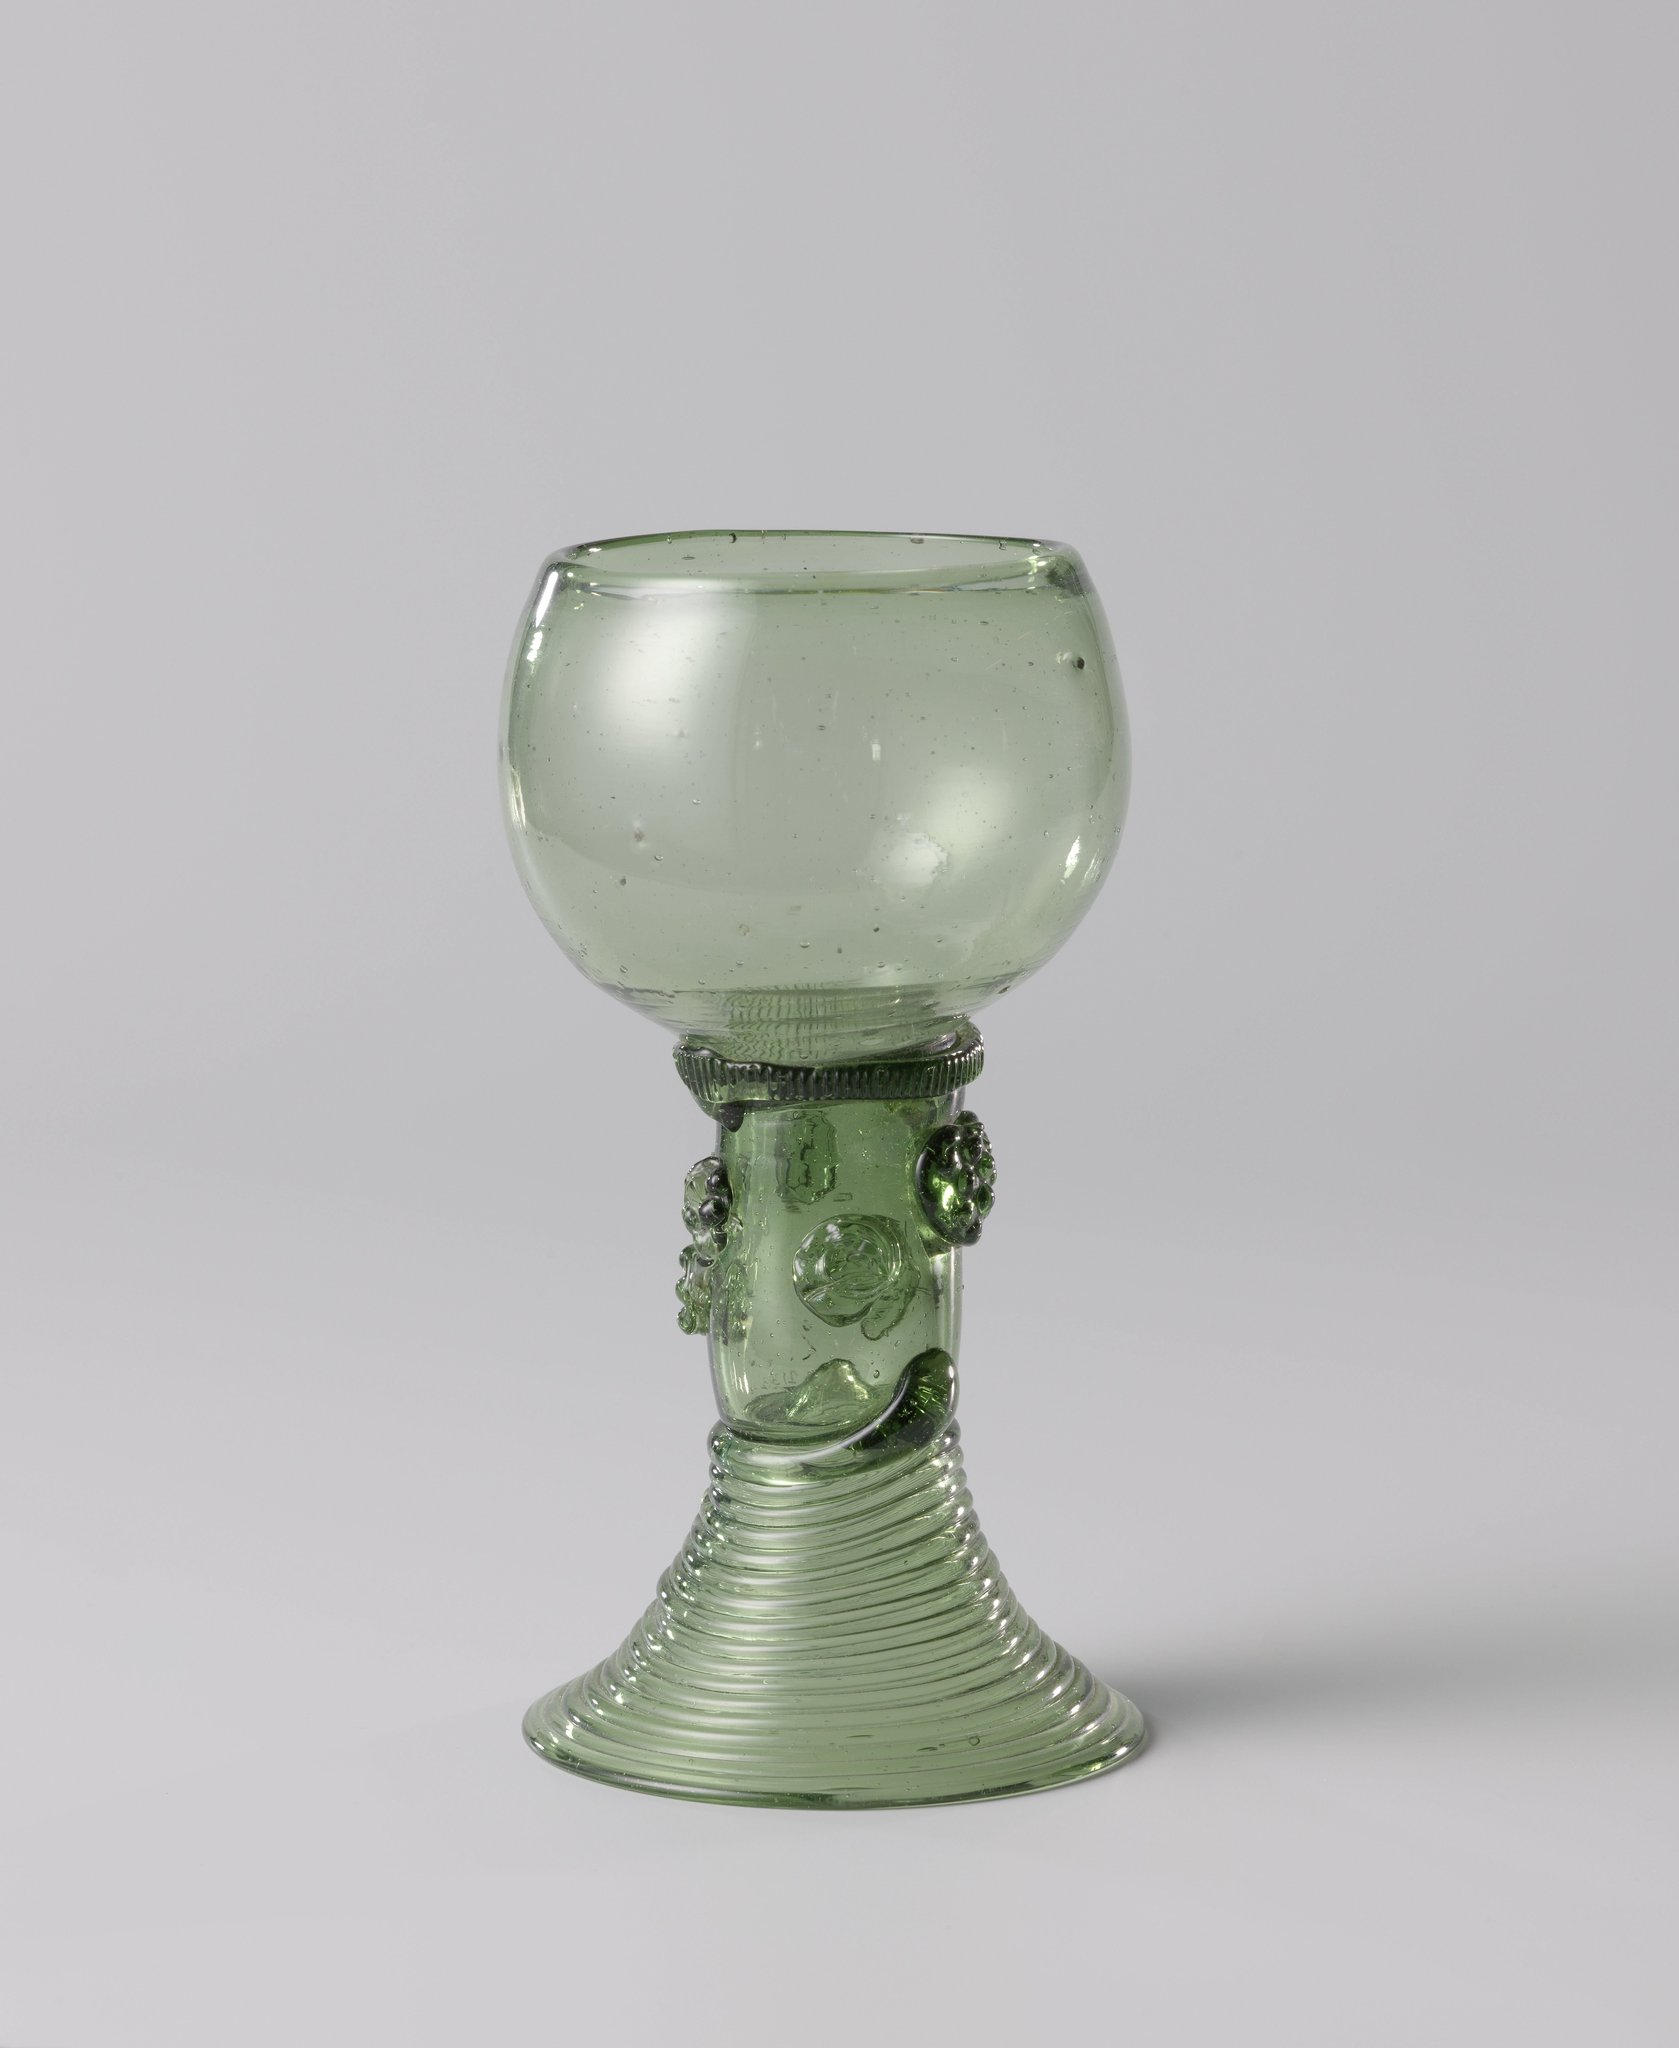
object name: roemer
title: Roemer met twee rijen braamnoppen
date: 1750-1810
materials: glass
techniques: glassblowing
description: Roemer met ingestoken bodem op hoge, concave, uit een draad gesponnen voet. De bolvormige kelk en de stam, die bezet is met twee rijen braamnoppen, zijn afzonderlijk geblazen. De overgang van de kelk naar de stam wordt aangegeven door een geribde draad